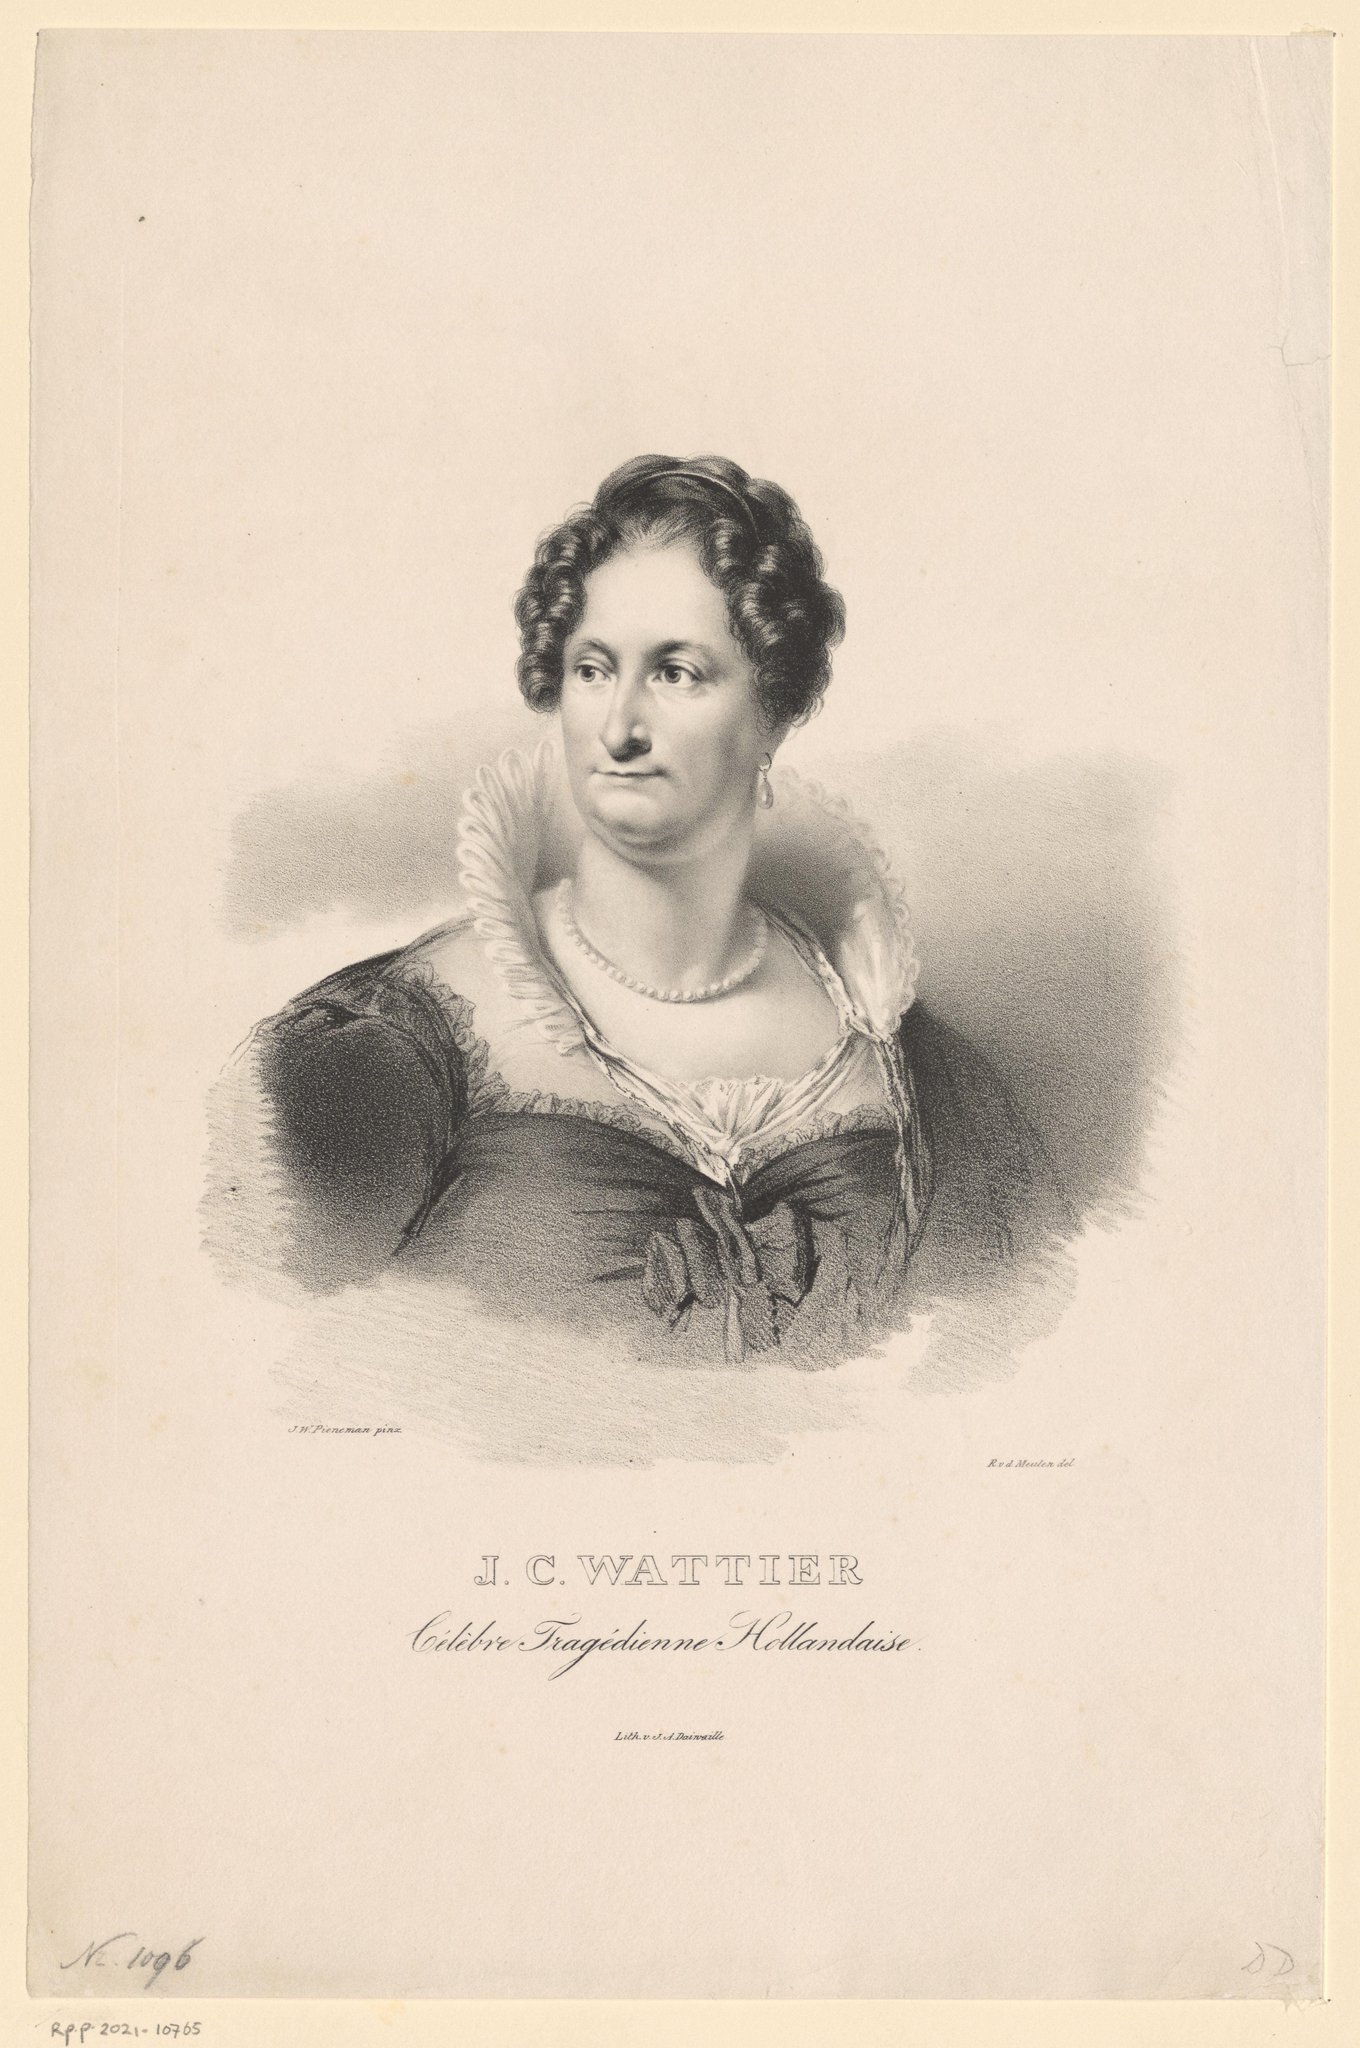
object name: print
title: Portret van Johanna Cornelia Wattier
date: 1816-1833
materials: paper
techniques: lithograph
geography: amsterdam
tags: rotterdam, voorburg, historical persons - bb - woman (+ (full) bust portrait), adult woman, historical persons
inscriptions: collector's mark: Lugt 12